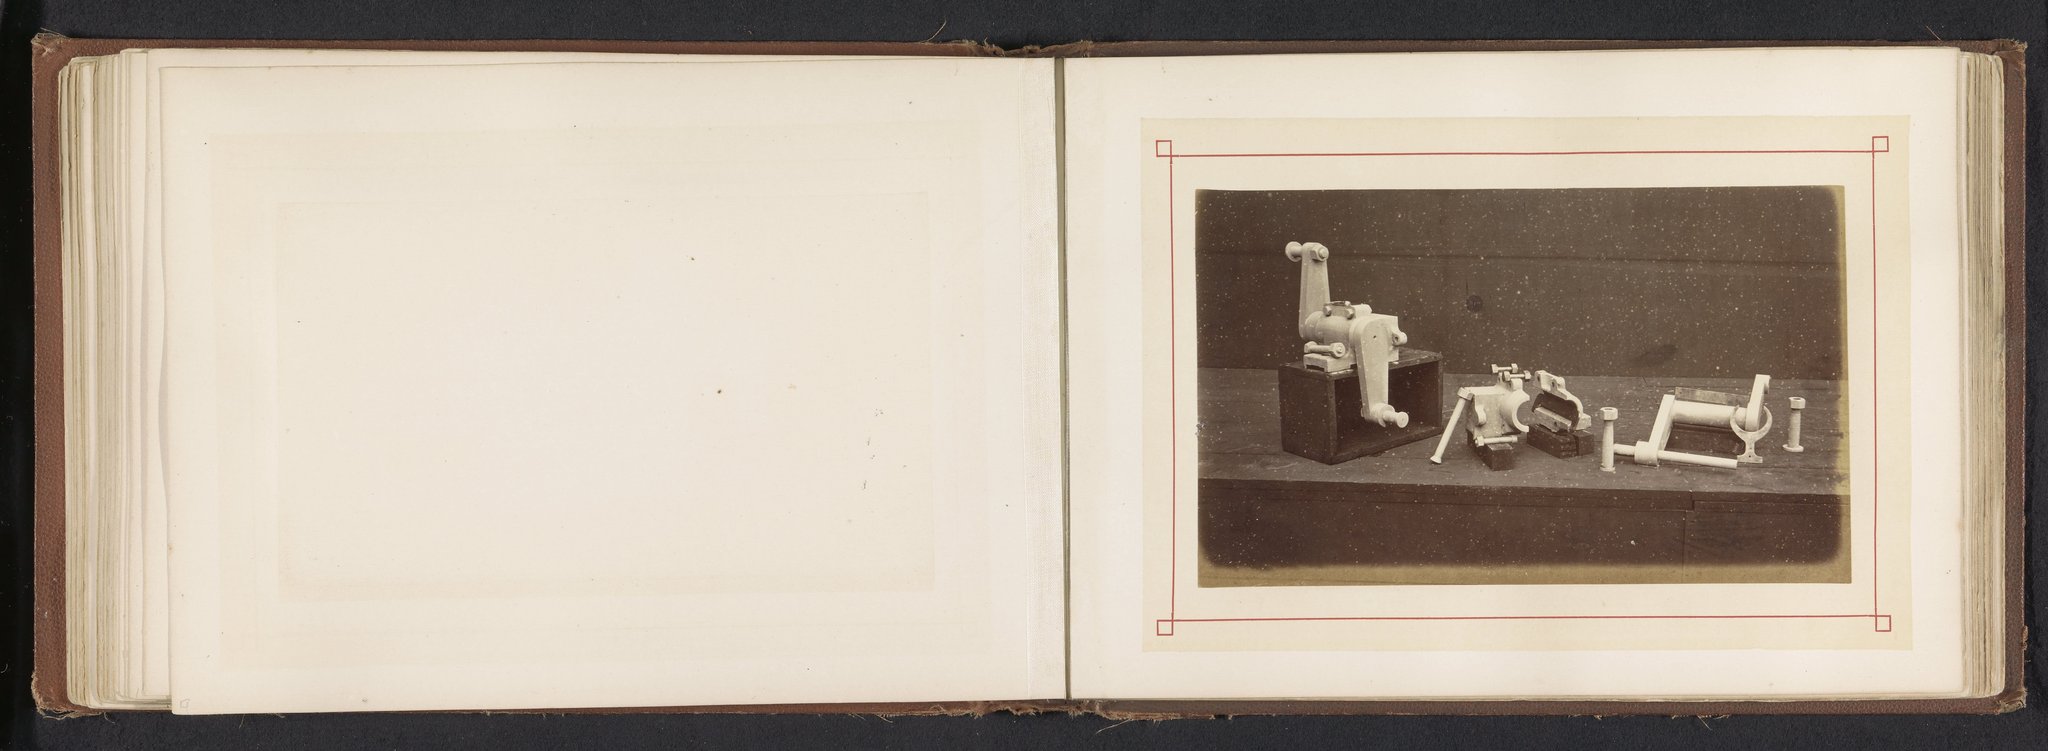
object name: photograph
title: Onderdelen van een stoomlocomotief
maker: george gardner rockwood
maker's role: fotograaf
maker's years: 1832-1911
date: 1861-1871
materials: photographic support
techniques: albumen print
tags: steam locomotive